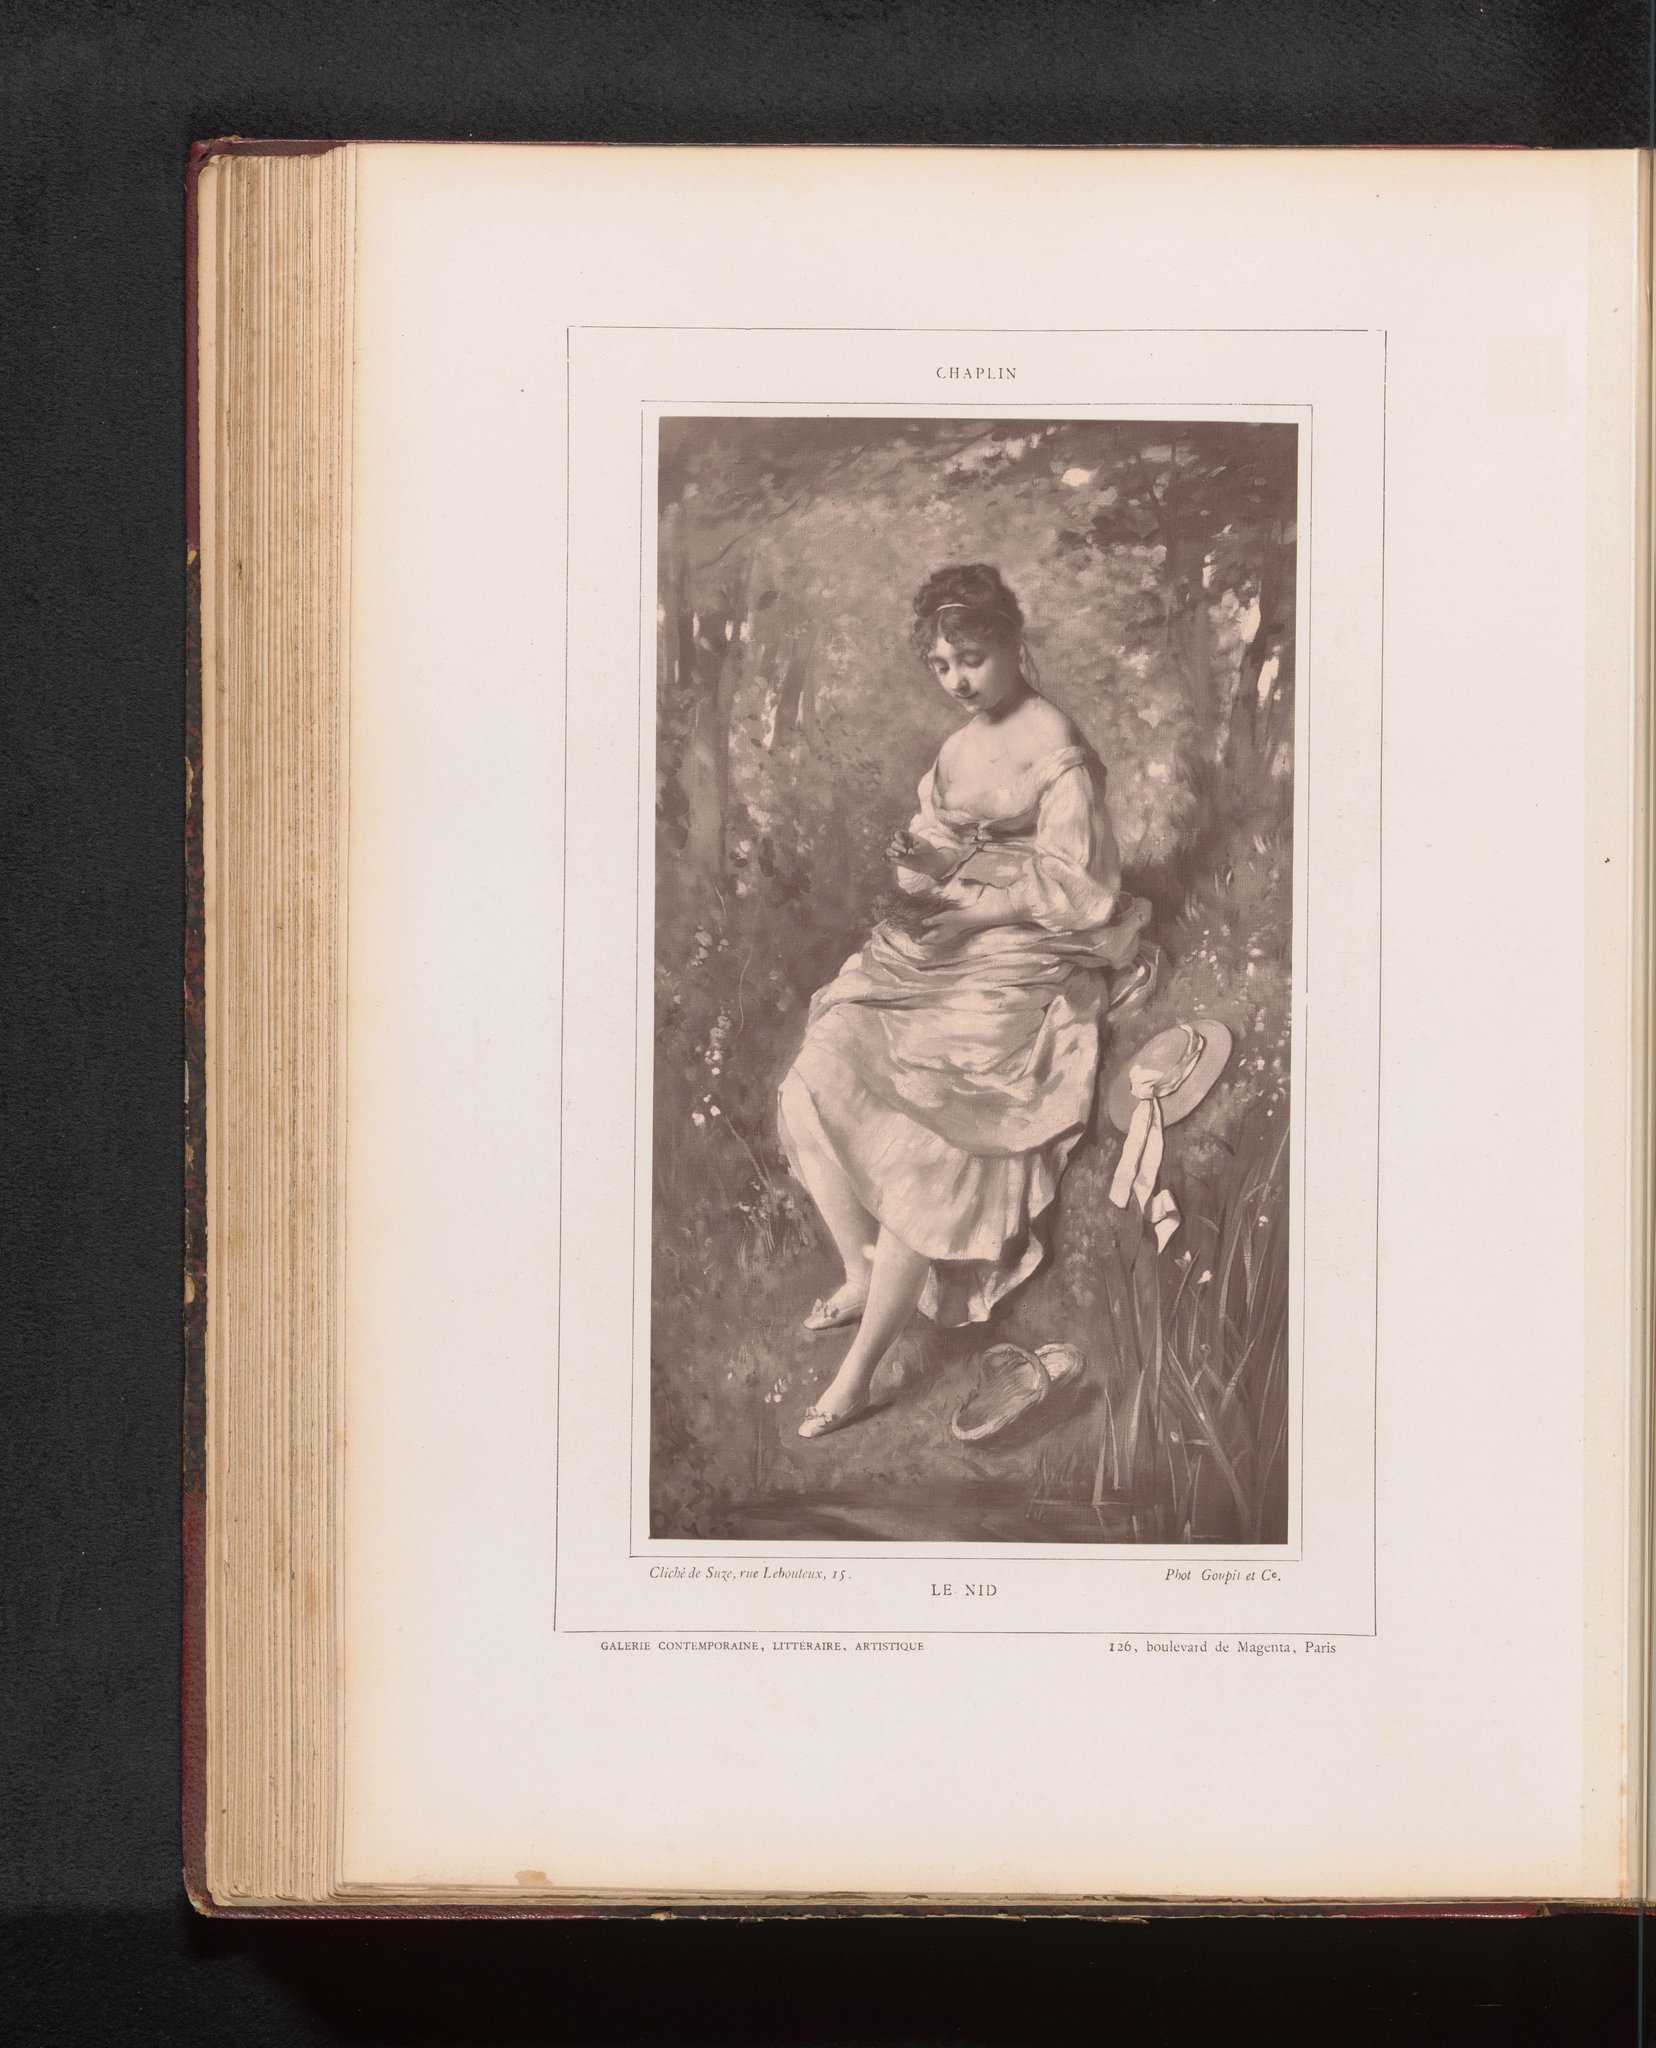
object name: photomechanical print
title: Reproductie van Le nid door Charles Joshua Chaplin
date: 1872-1877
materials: paper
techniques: woodburytype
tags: adult woman, painting, drawing and the graphic arts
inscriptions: inscription: ‘Chaplin/ Galerie Contemporaine/ 126, boulevard Magenta. - Paris’